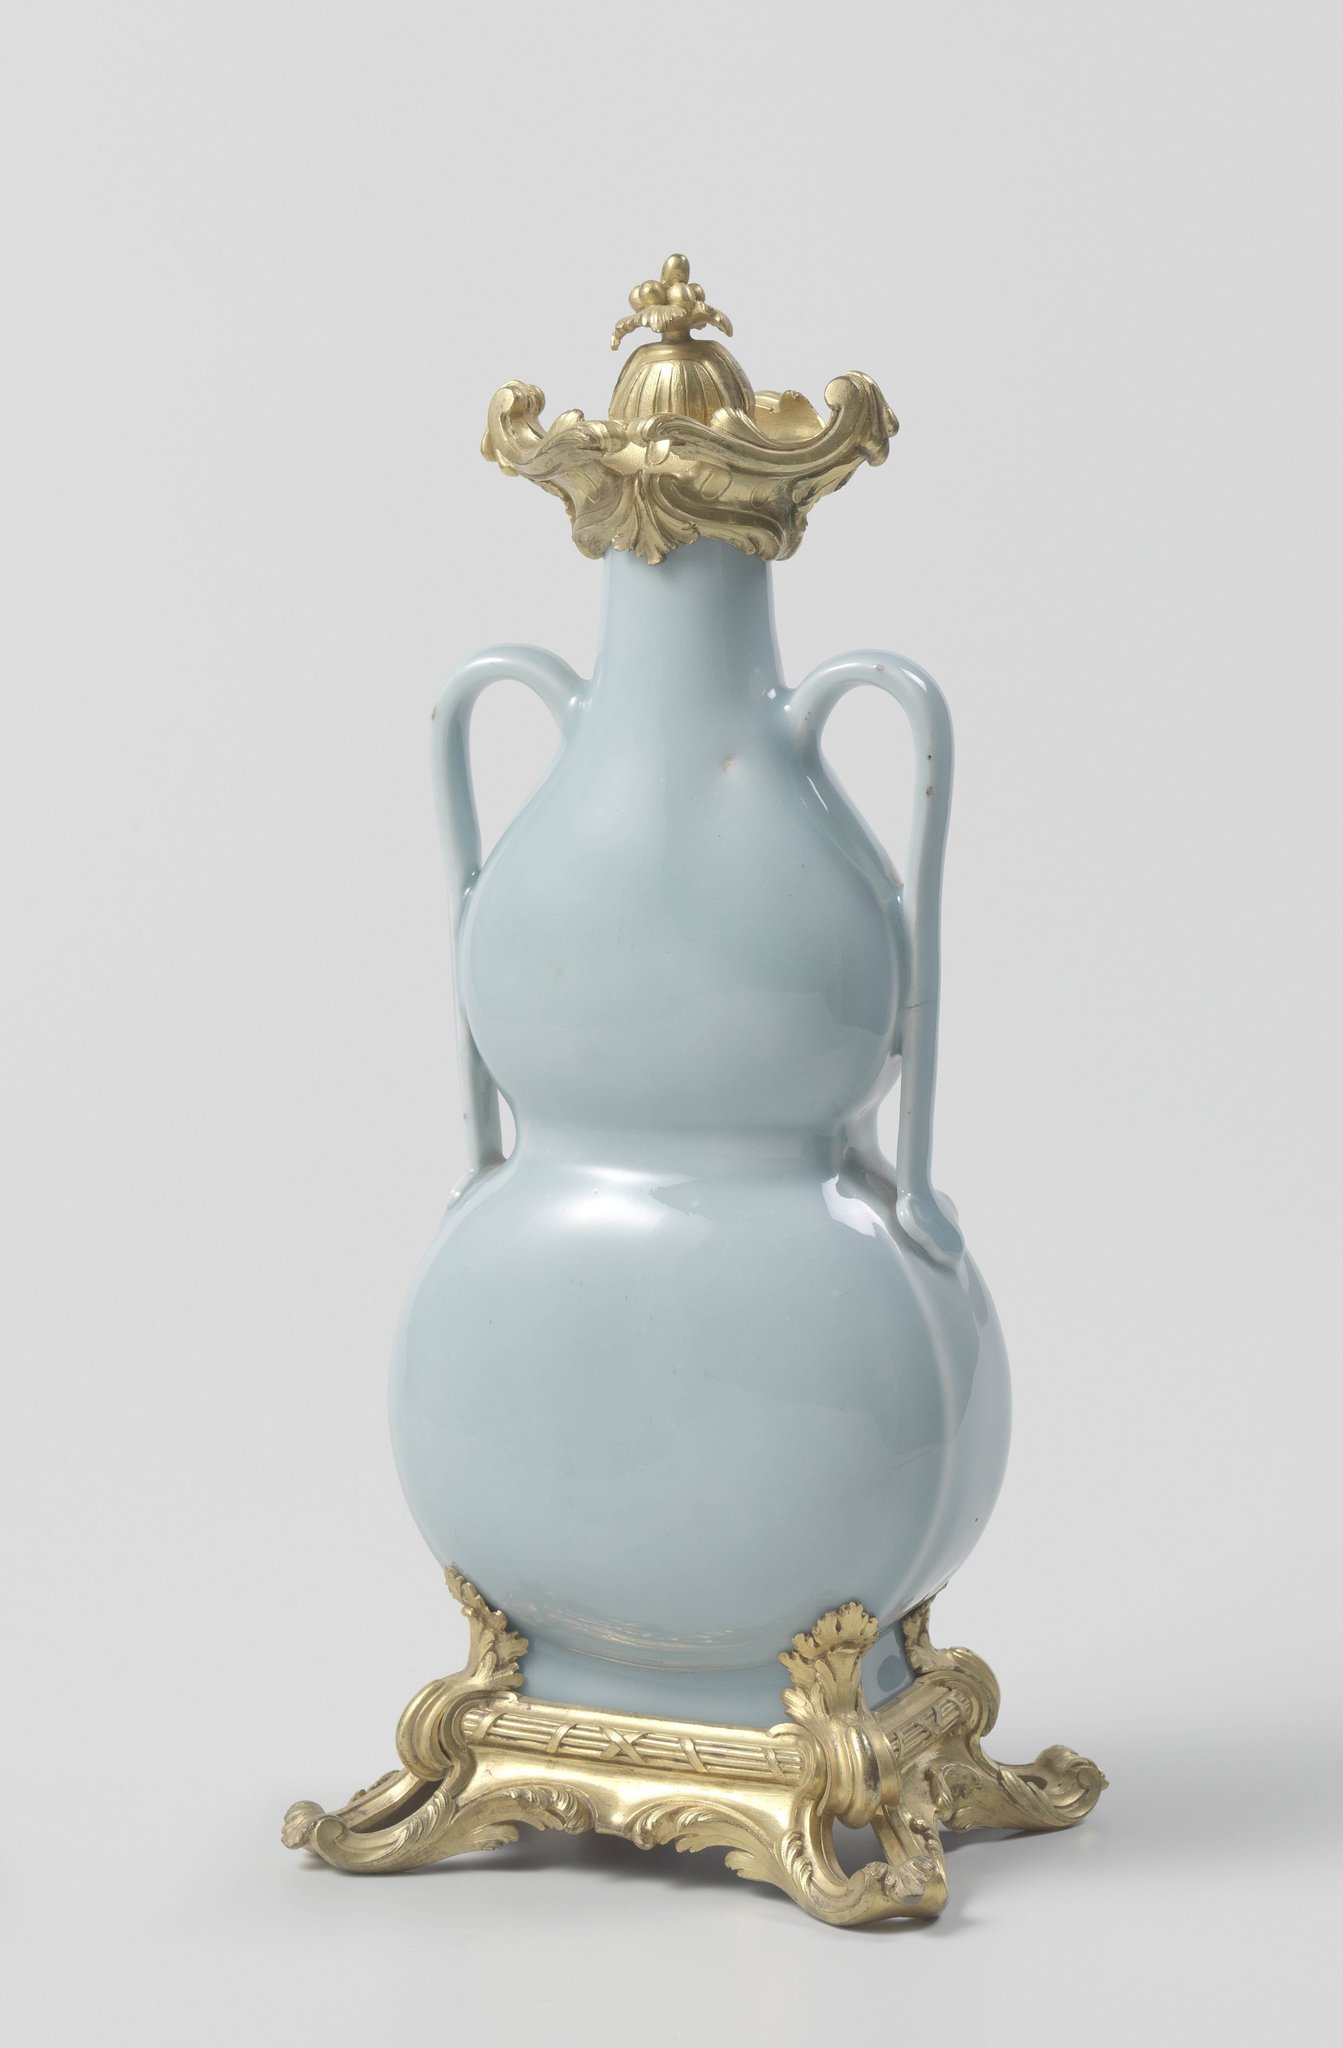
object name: vase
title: Pair of vases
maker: Anonymous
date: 1720-1750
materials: bronze, glaze, porcelain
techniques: gilding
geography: paris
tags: ornaments ~ art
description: Originally made in China, these gourd vases were fitted in Paris with fashionable gilt-bronze mounts, with pagoda-shaped lids. In this way the French craftsman adapted an exotic object to Western taste. With their gilding, the vases matched the other furnishings in a luxuriously appointed interior.